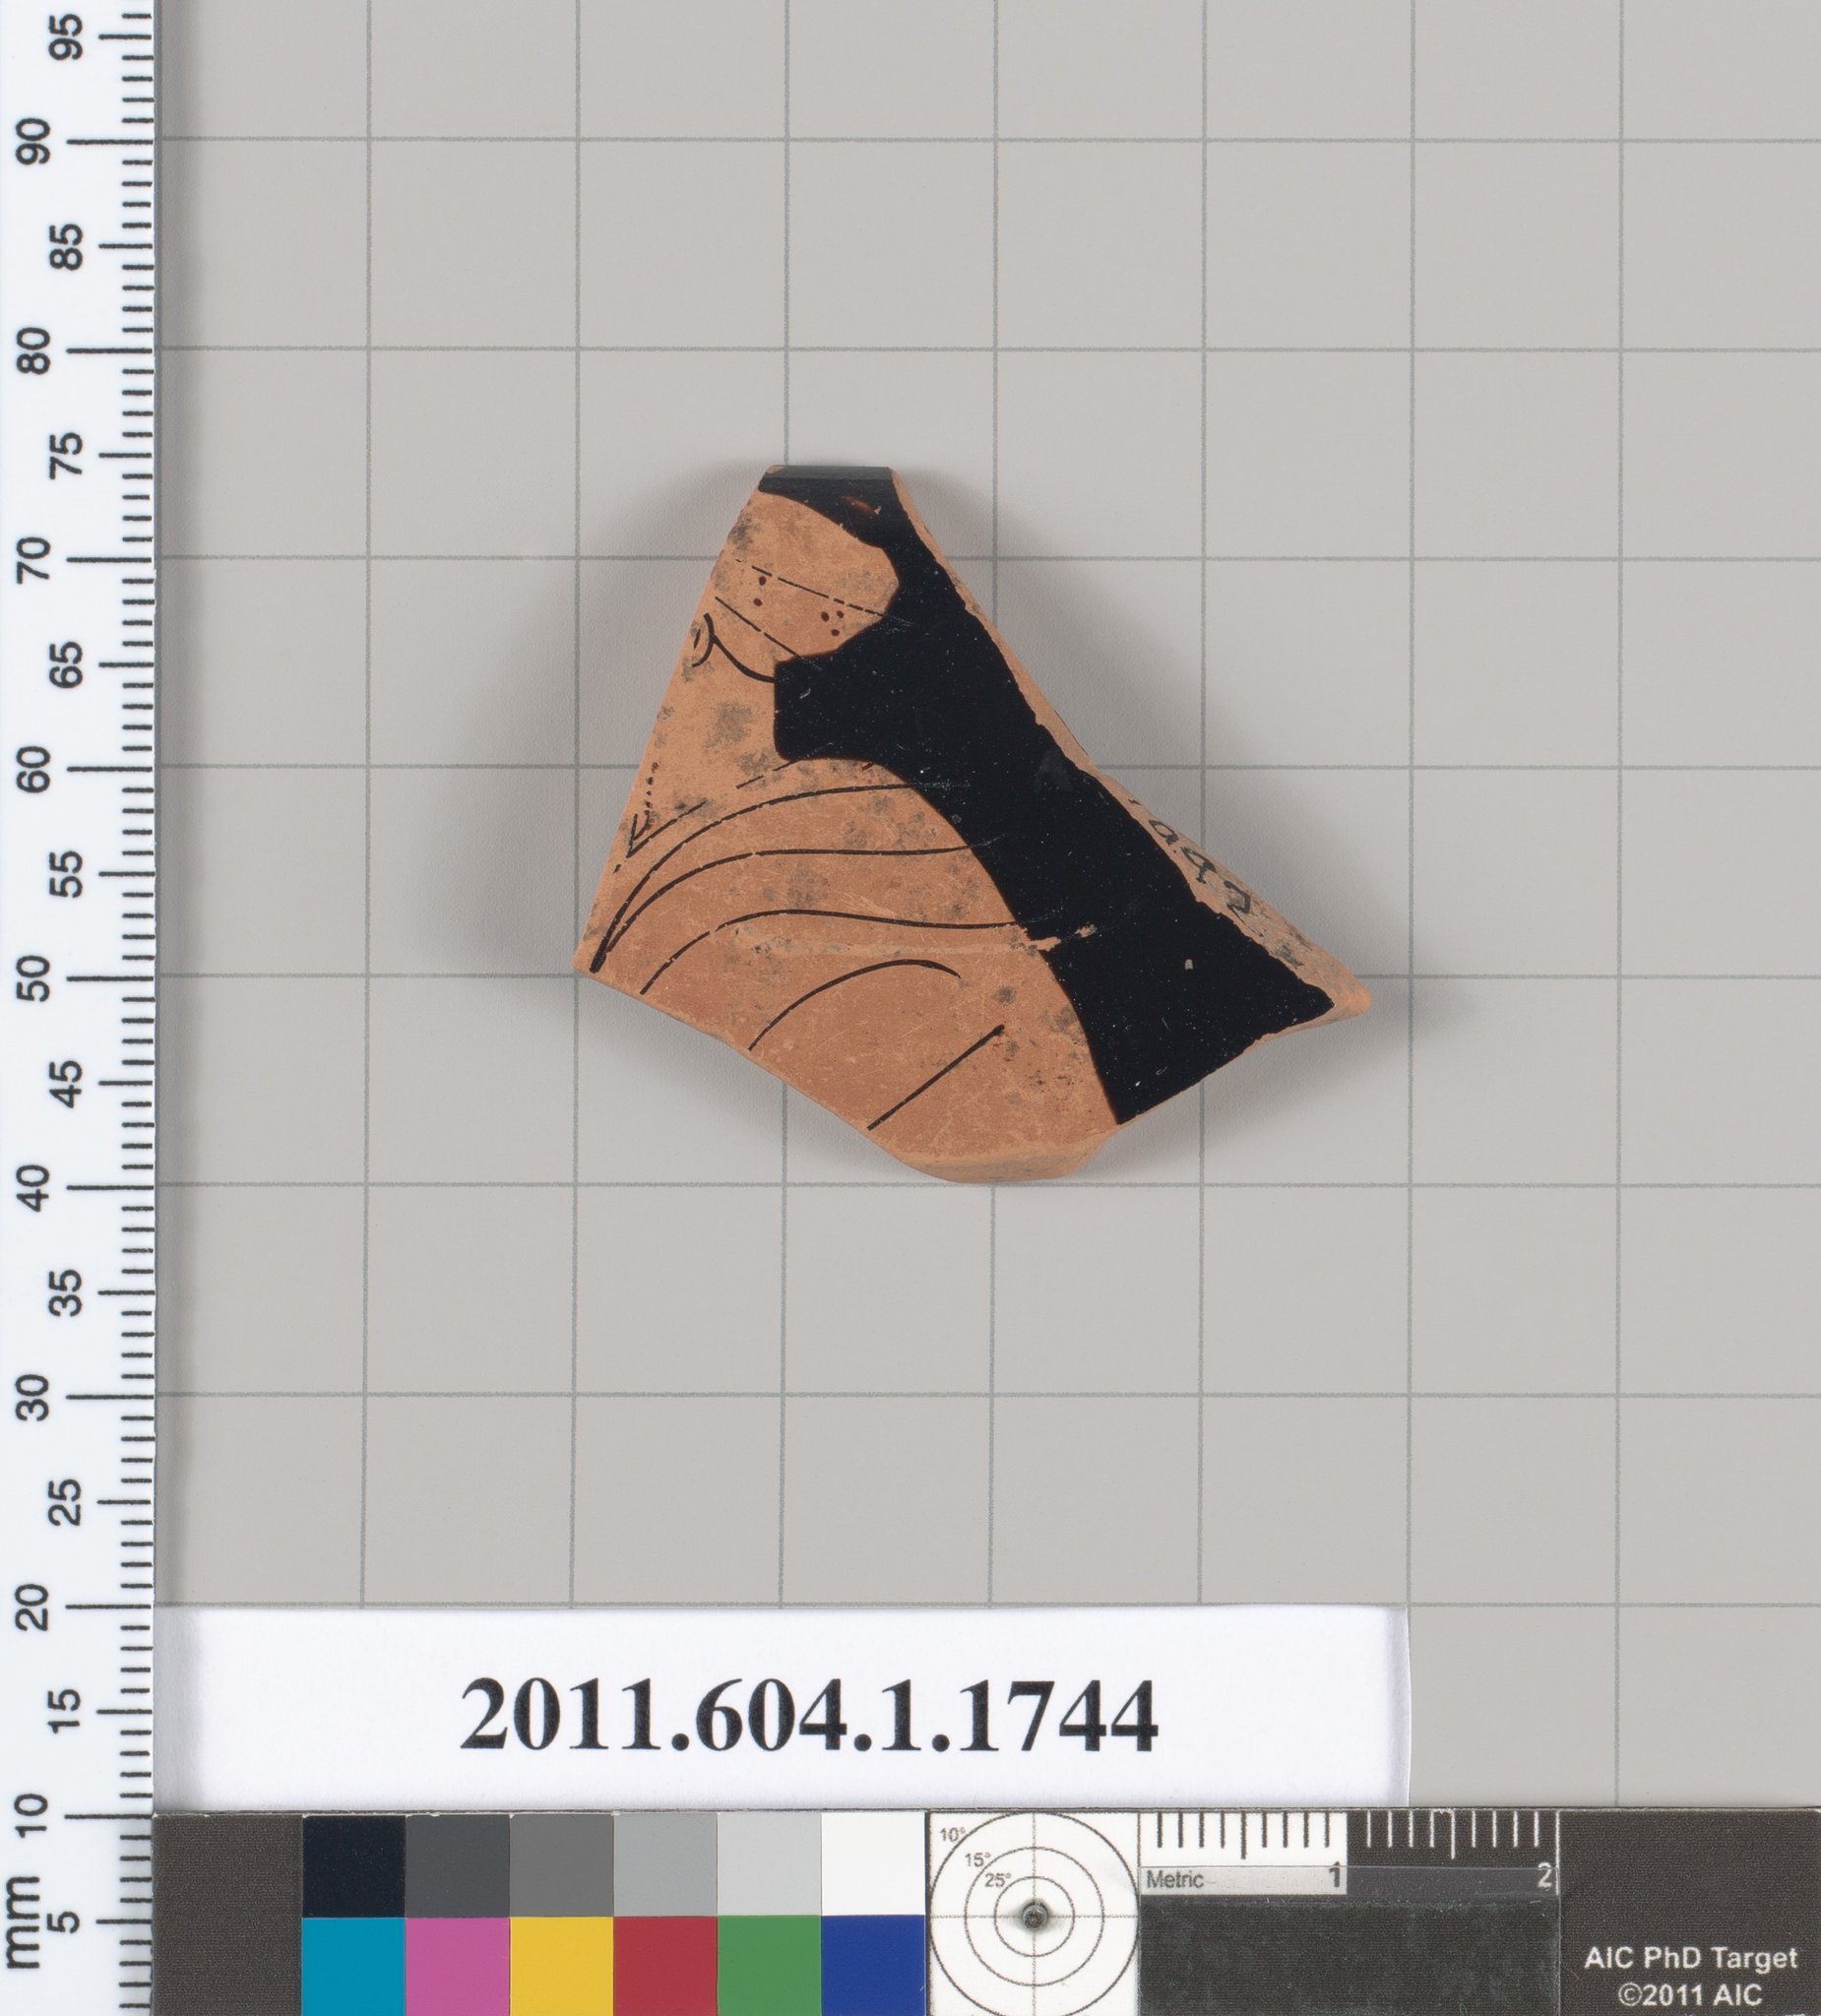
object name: kylix fragment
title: Terracotta rim fragment of a kylix (drinking cup)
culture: greek, attic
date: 475-451 BCE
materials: terracotta